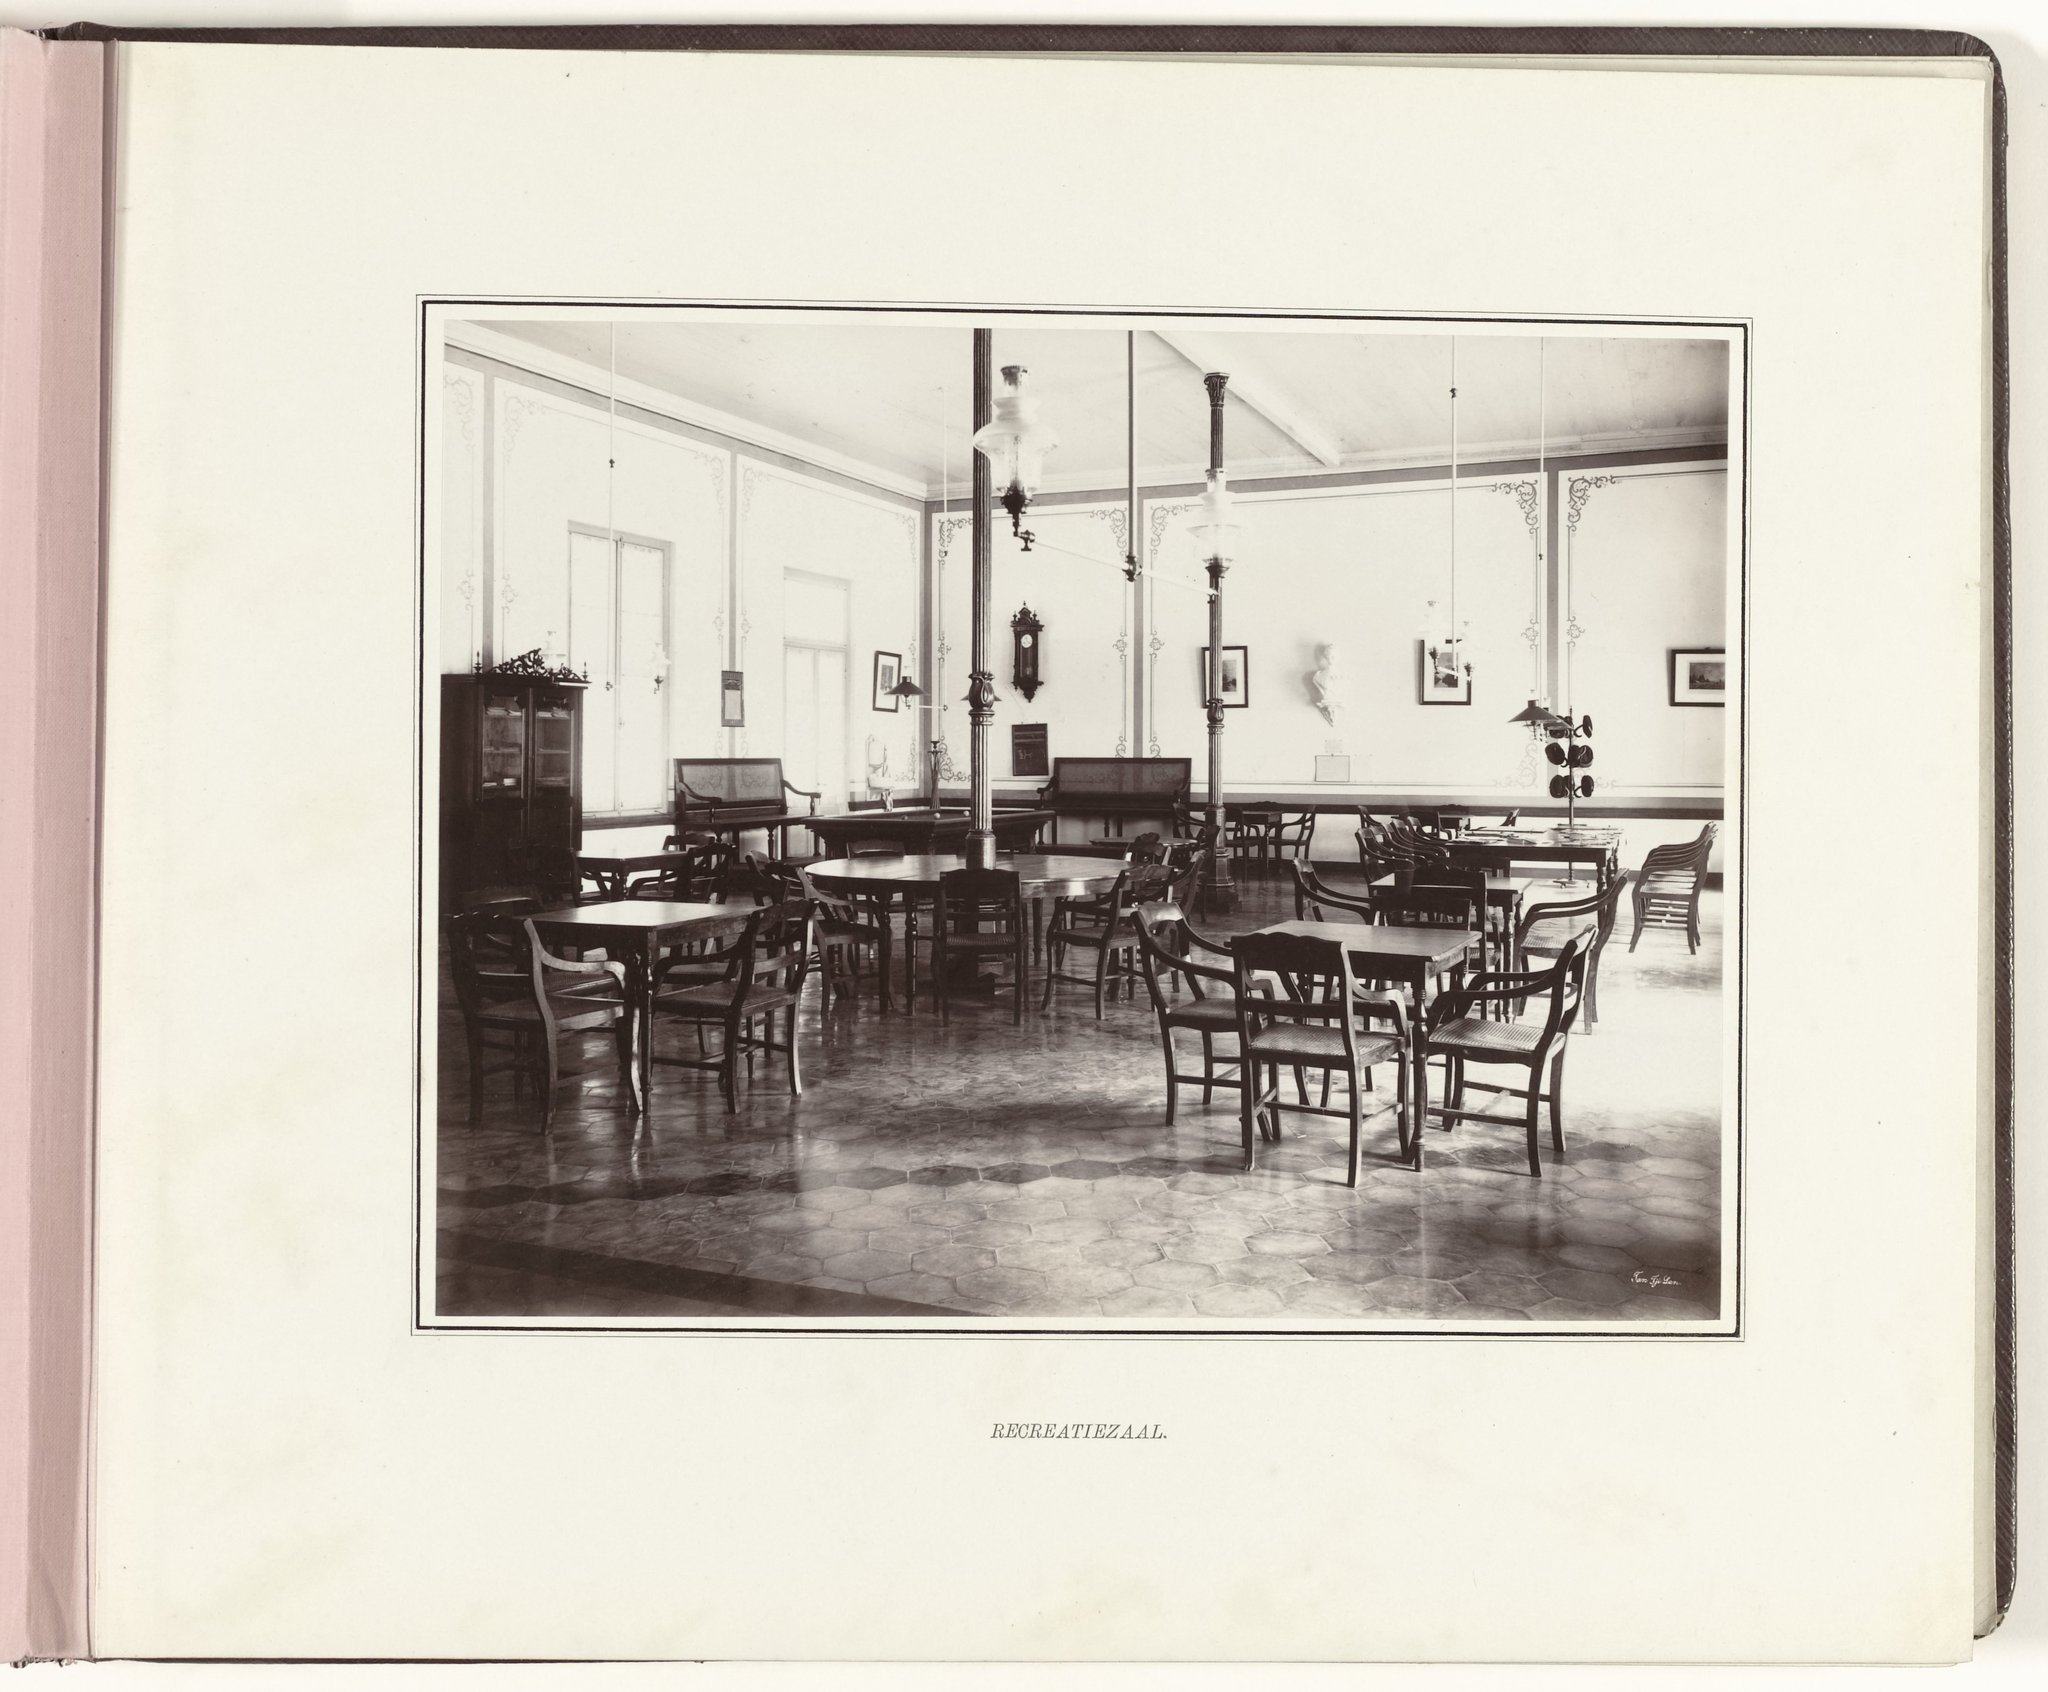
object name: photograph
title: Recreatiezaal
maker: tan tjie lan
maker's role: fotograaf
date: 1902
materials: photographic support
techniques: albumen print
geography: weltevreden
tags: colonial system, vocational education, e.g.: junior technical school (+ building ~ education, tuition)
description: Recreatiezaal in de School tot Opleiding van Inlandse Artsen (STOVIA) te Weltevreden. Zaal met tafels en stoelen. Ingeplakte foto in het album van ca. 1902 getiteld: School tot Opleiding van Inlandsche Geneeskundigen / Ter Herinnering aan de Inhuldiging van Koningin Wilhelmina en tot Heil der Bevolking van Nederlandsch Oost-Indie.